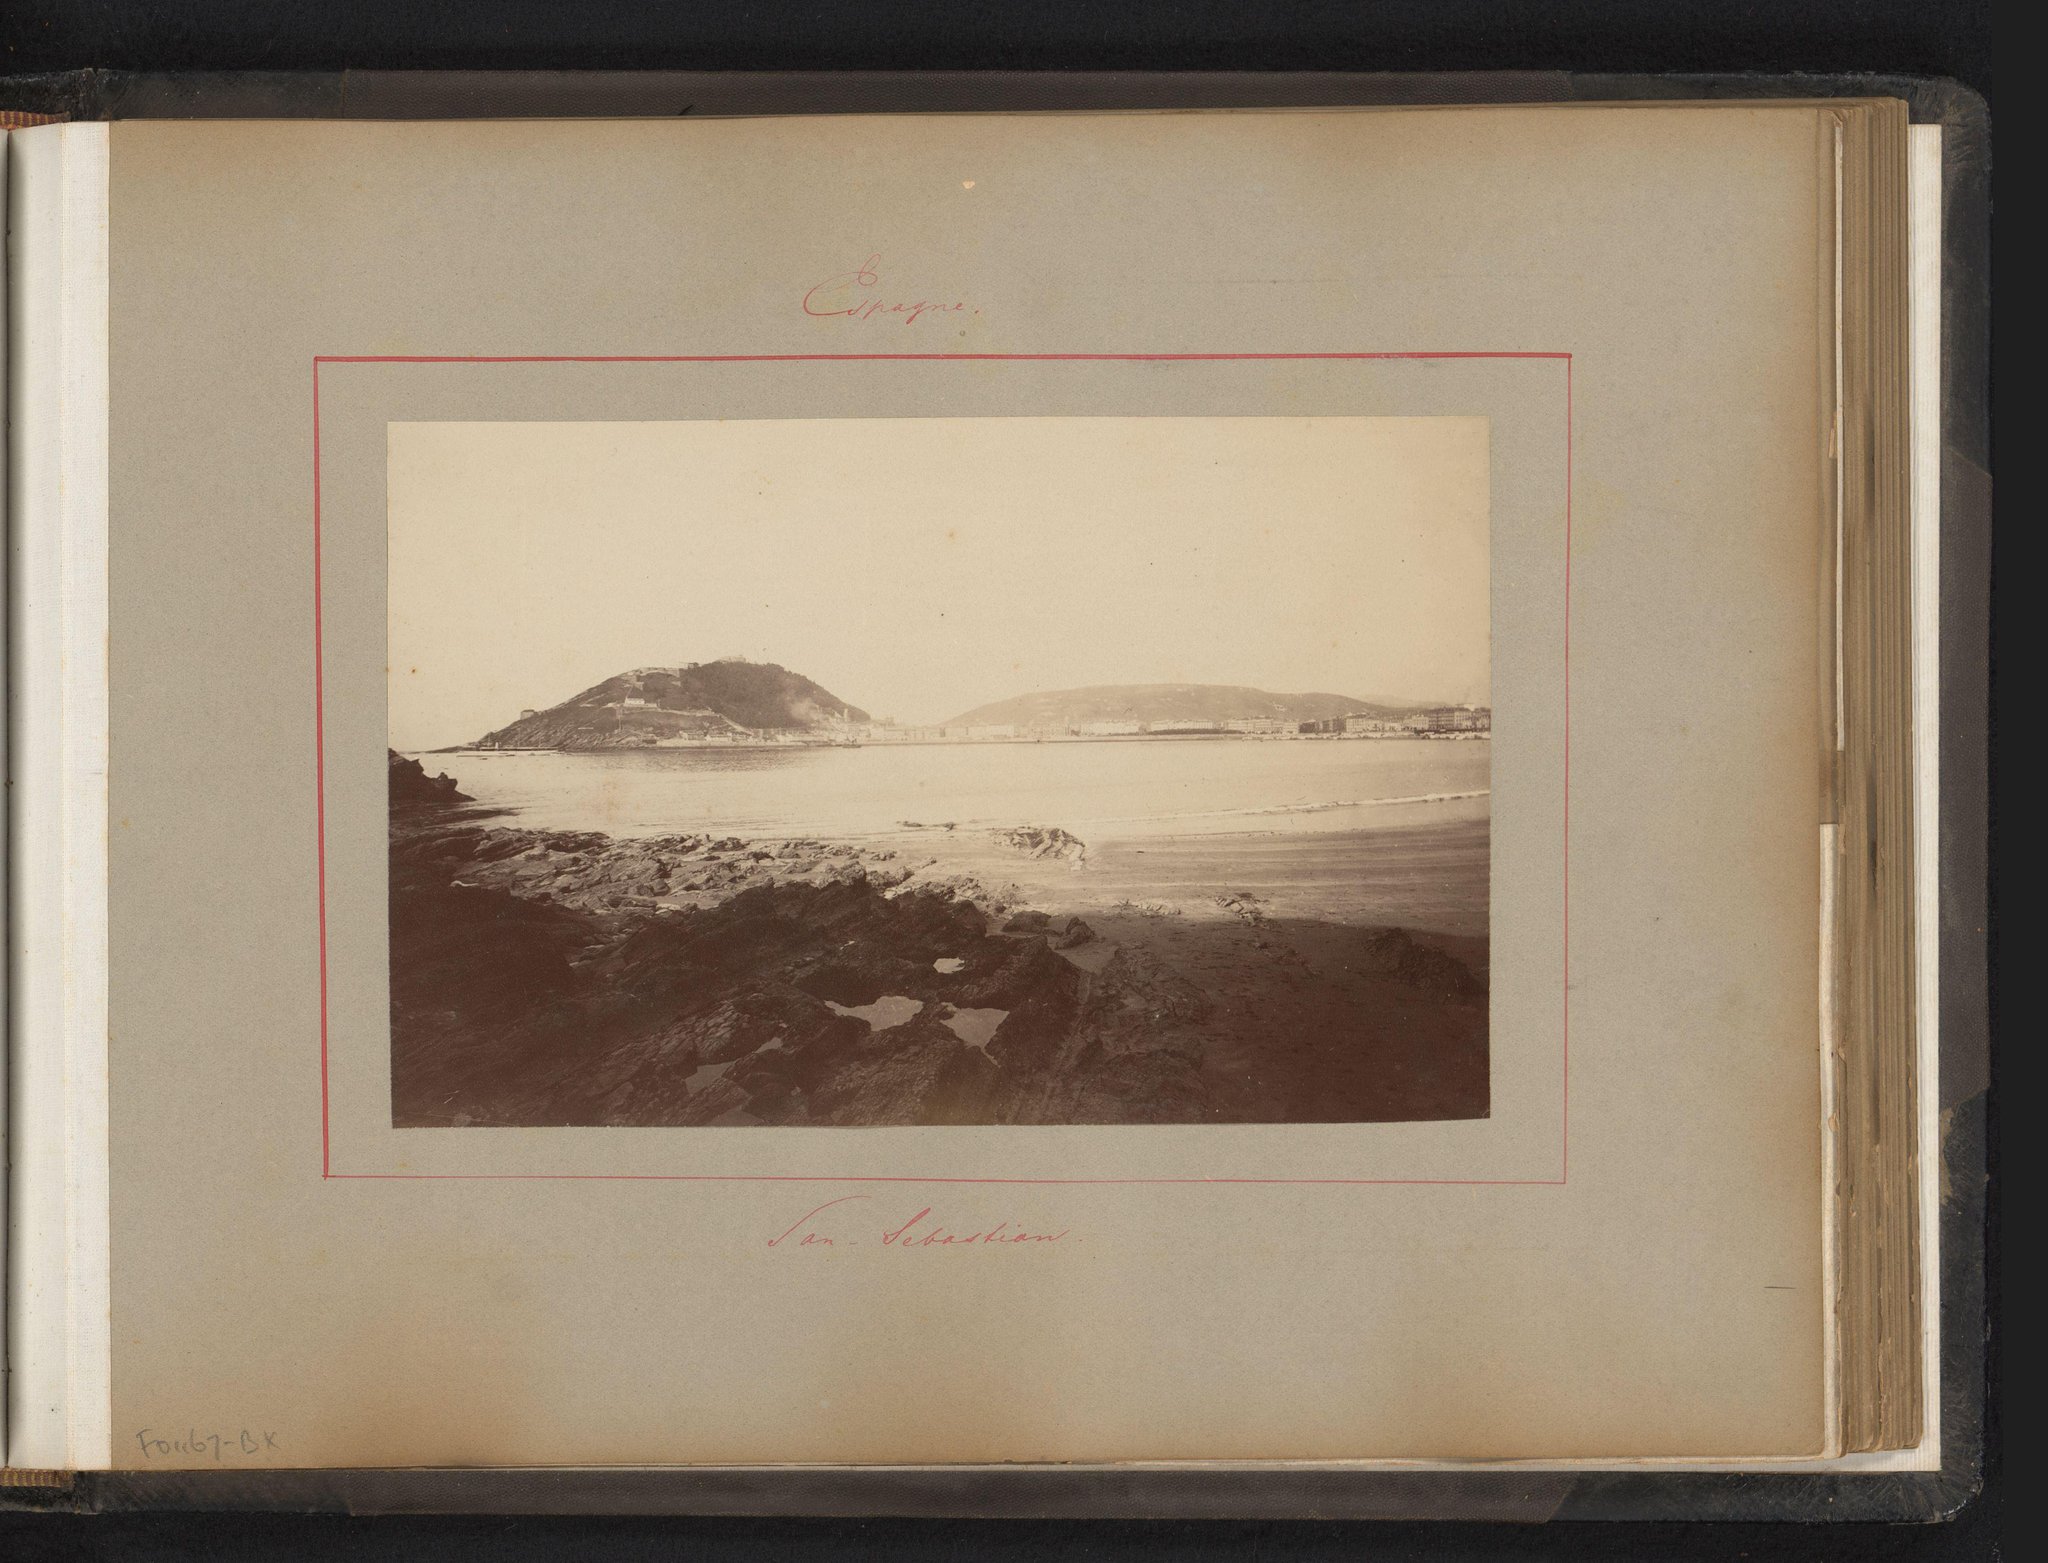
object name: album leaf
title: Gezicht op San Sebastian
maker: Anonymous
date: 1880-1910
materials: photographic support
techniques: albumen print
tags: city-view in general; 'veduta', sea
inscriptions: annotation: ‘Espagne/ San Sebastian’